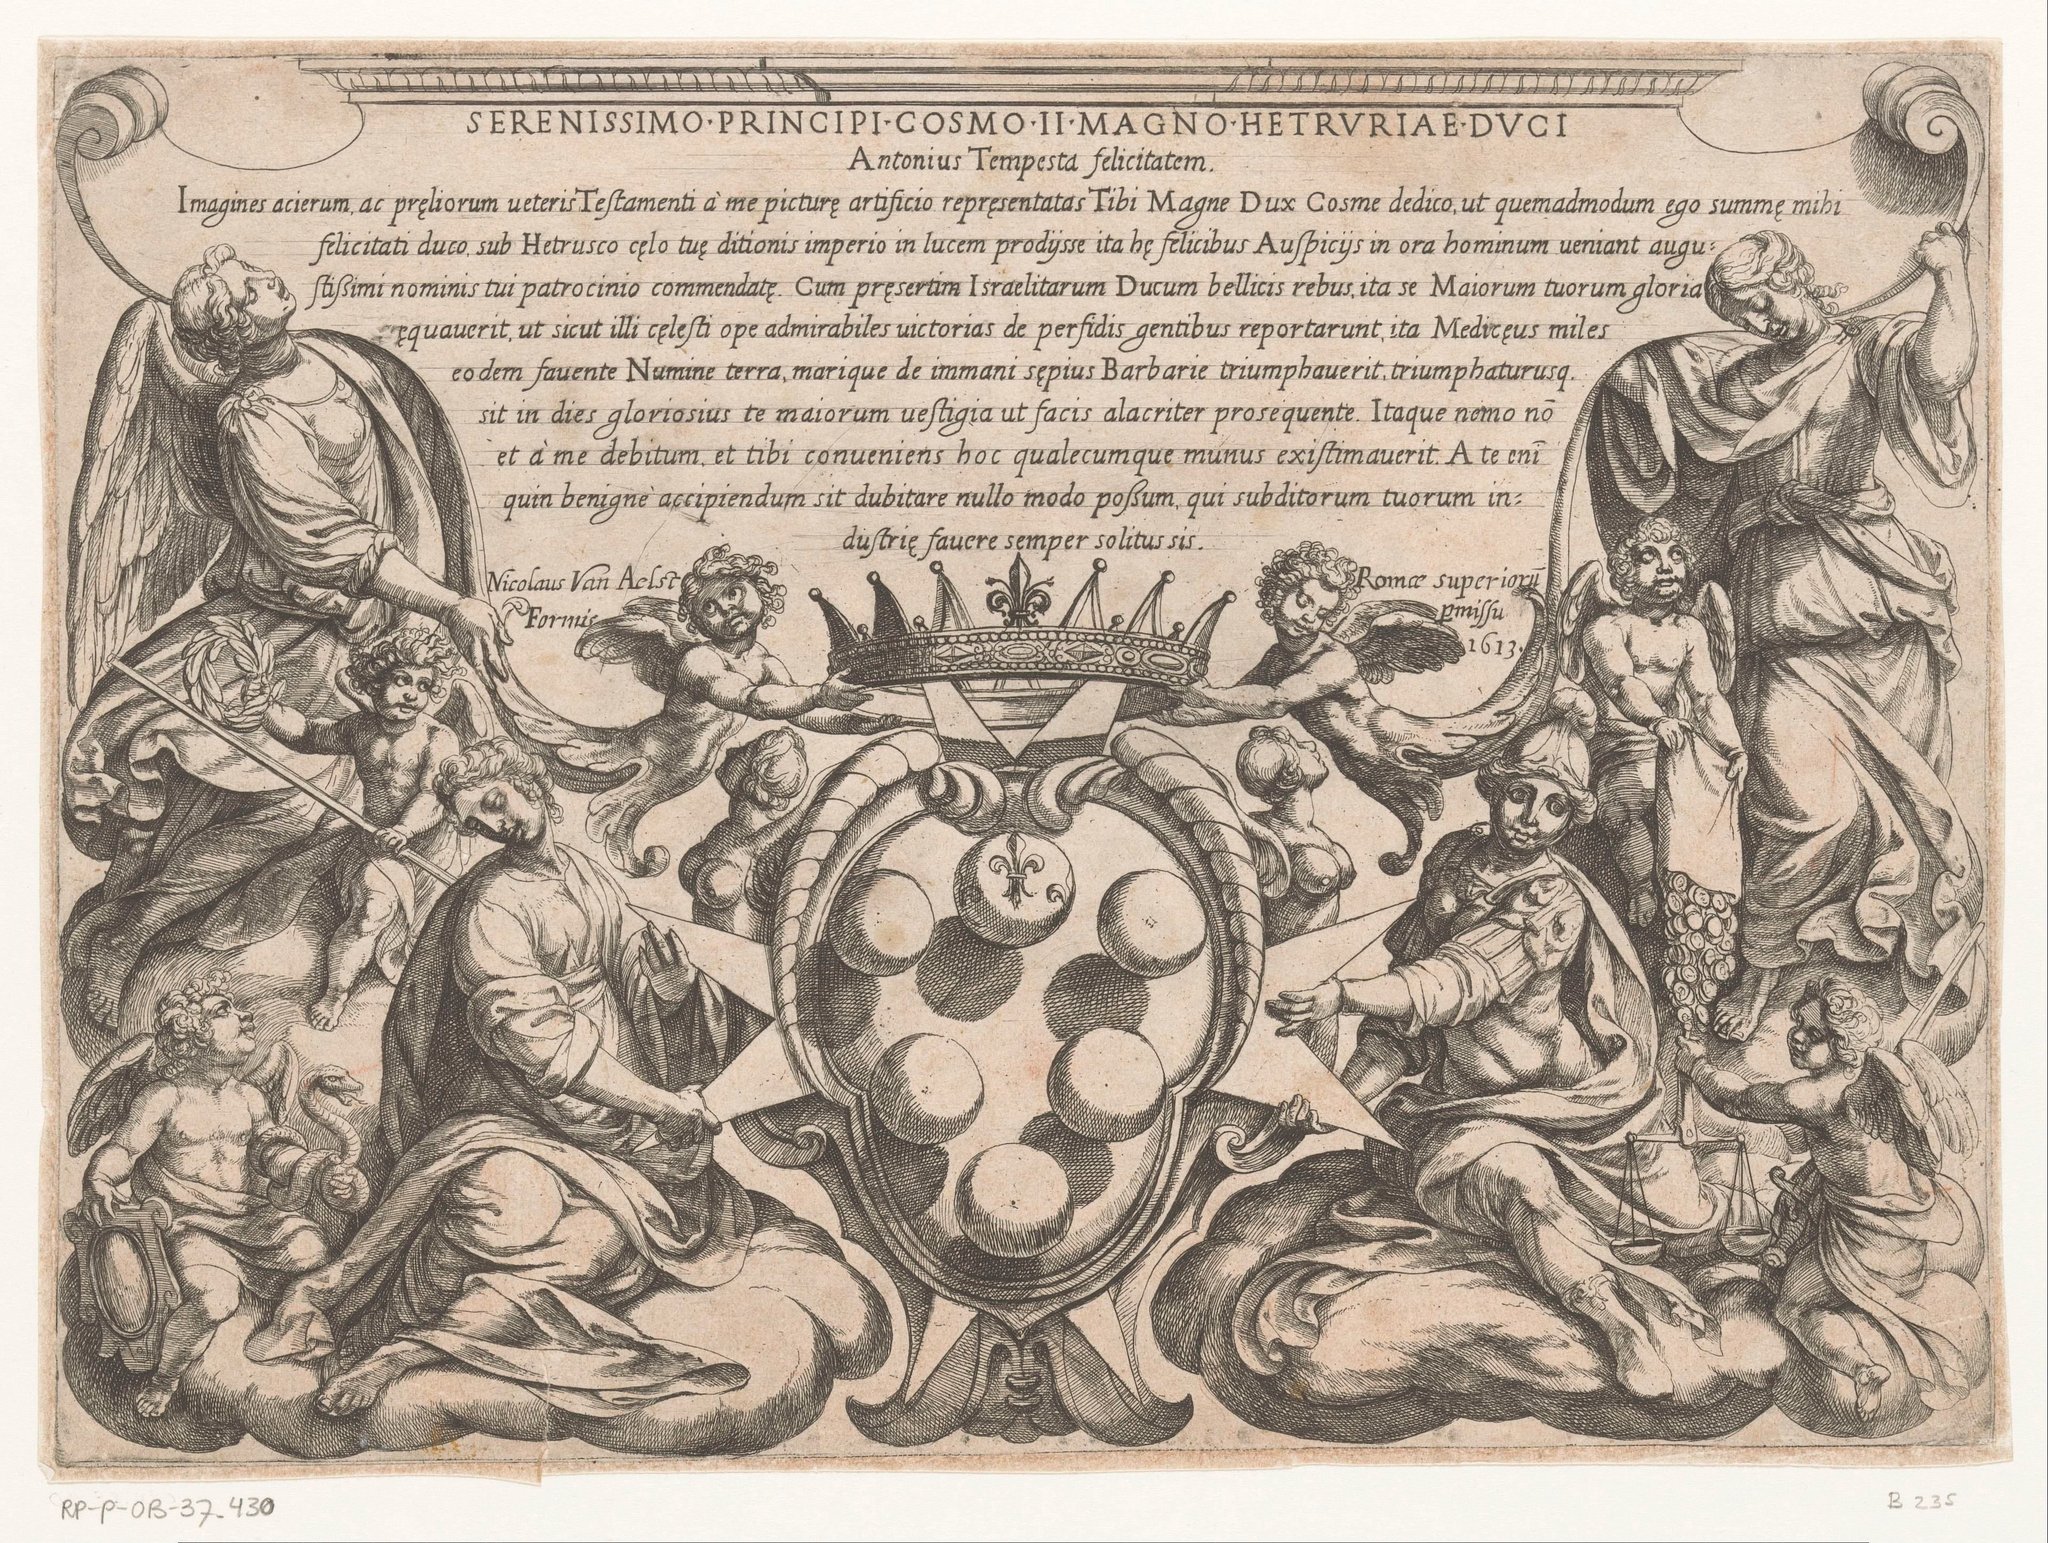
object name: titelprent, frontispice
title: Oudtestamentische strijdscènes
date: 1613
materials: paper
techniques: etching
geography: rome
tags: coat of arms (symbol of sovereignty), justitia (justice) as roman personification, fama as roman personification, generosity, liberality; 'generosità', 'liberalità' (ripa), cupids: 'amores', 'amoretti', 'putti', prudentia (prudence) as roman personification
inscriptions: date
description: Titelprent bij een reeks van 24 prenten met oudtestamentische strijdscènes.